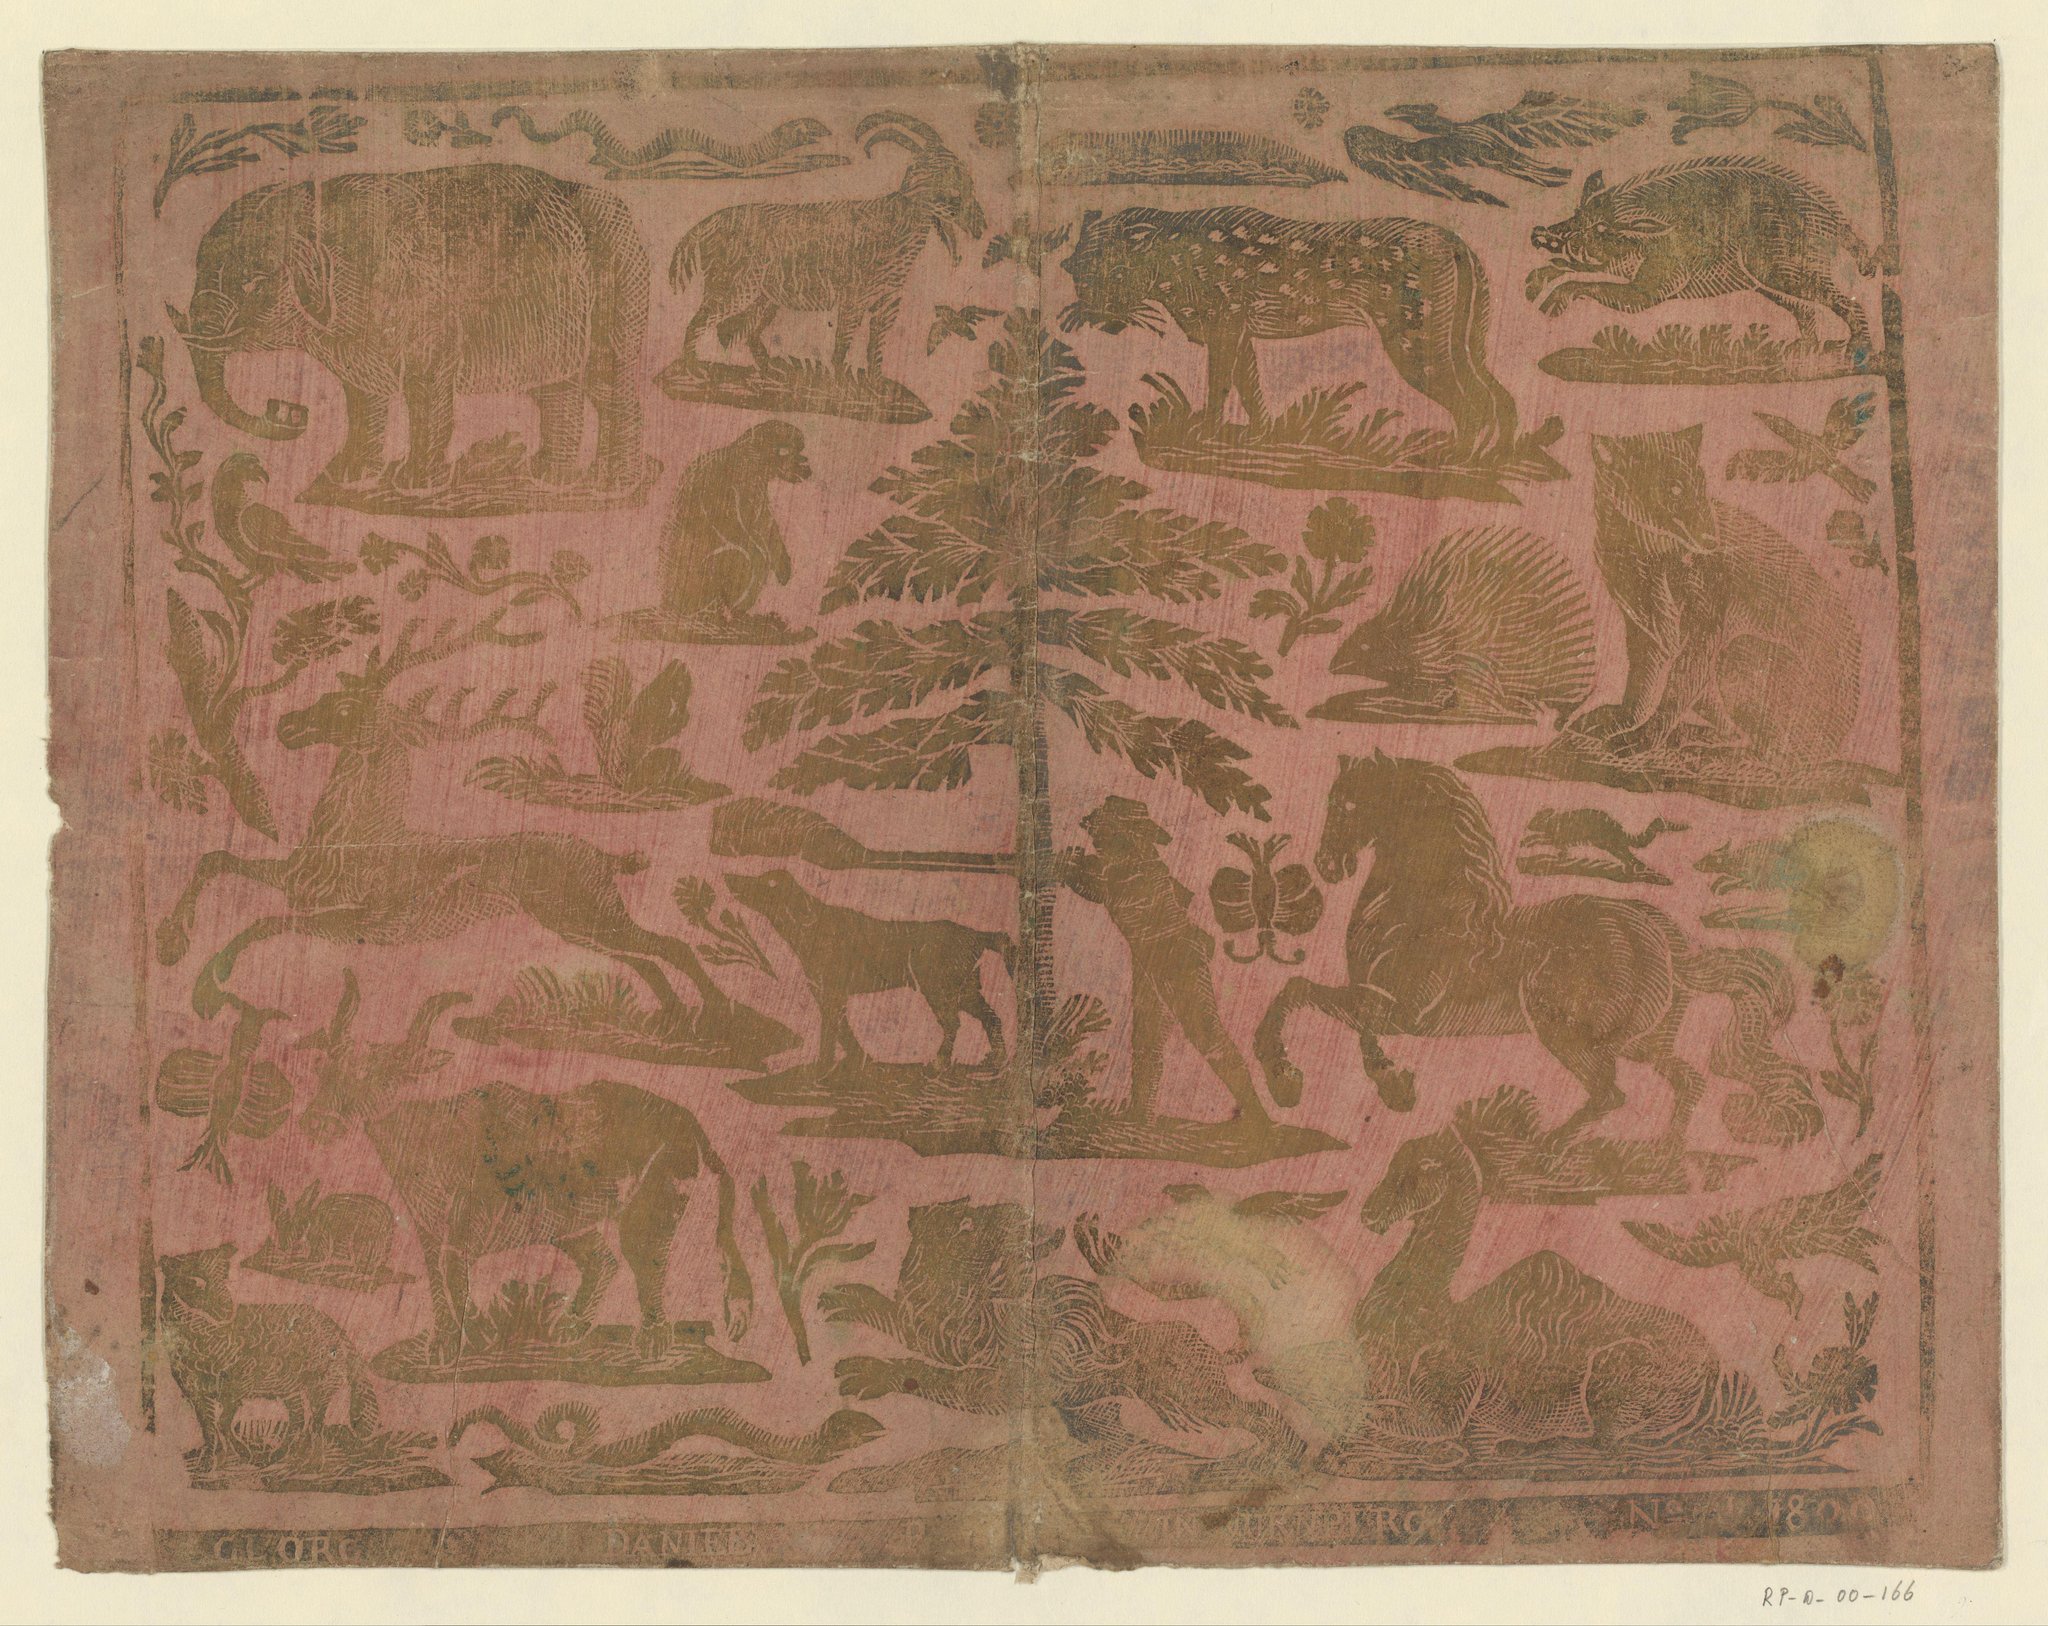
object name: brocade paper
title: Blad met dieren met in het midden een jager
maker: georg daniel reimund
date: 1800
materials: gold leaf, paint, paper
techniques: relief print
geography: nuremberg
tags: animals, cattle, hunters hunting (n.b.: in 1988-1990 this notation denoted the concept of 43c11421 'hunters resting during the hunt'), dog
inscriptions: date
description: Blad met dieren; linksboven olifant, rechtsboven wild zwijn, linksonder schaap, rechtsonder dromedaris, centraal een schietende jager onder een boom. Onderaan genummerd: 1.